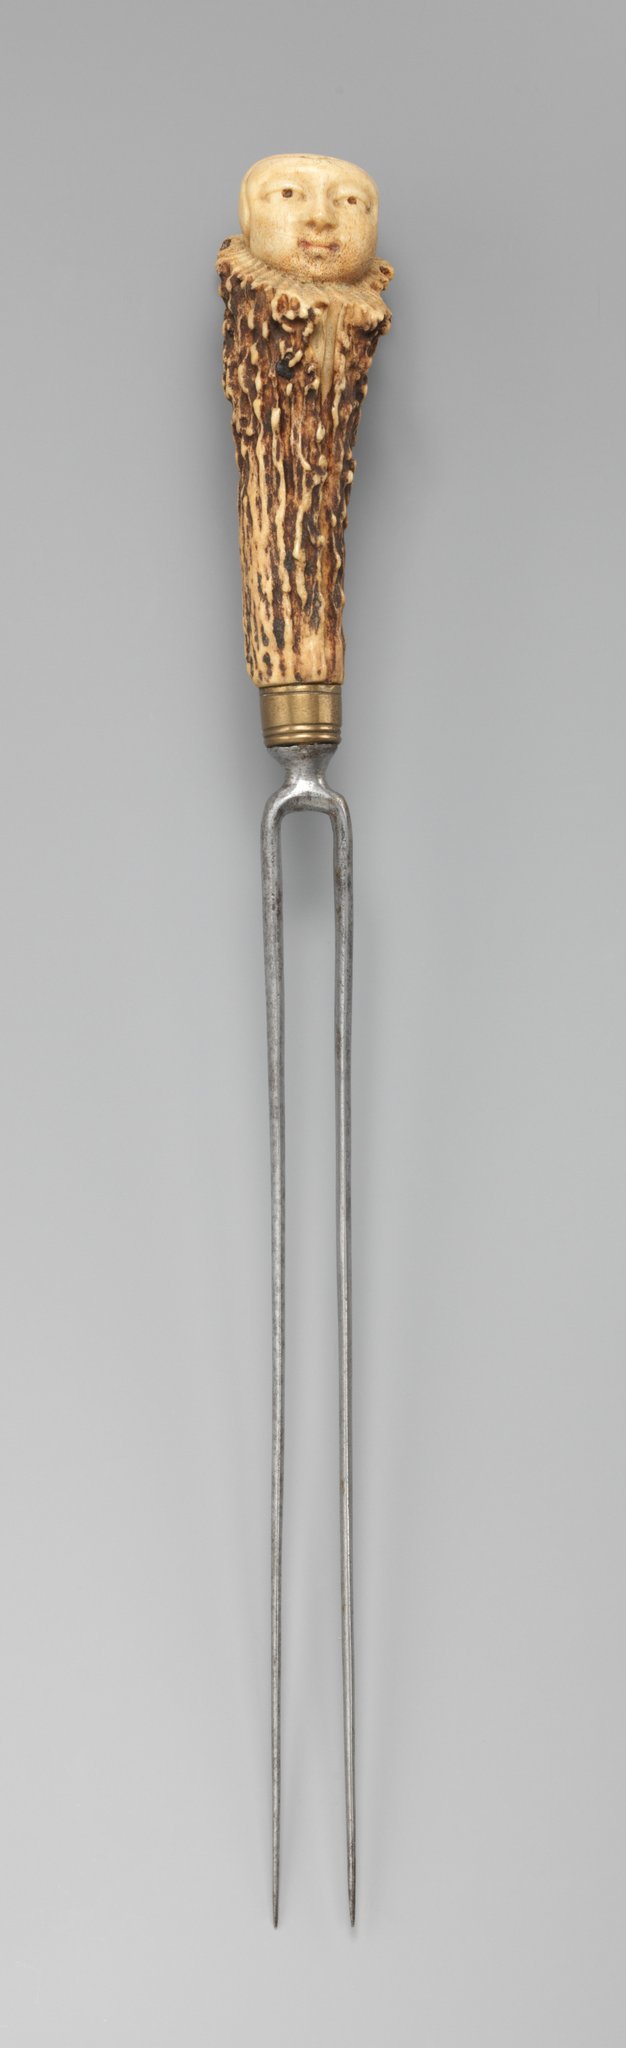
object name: fork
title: Carving fork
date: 1801-1900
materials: steel